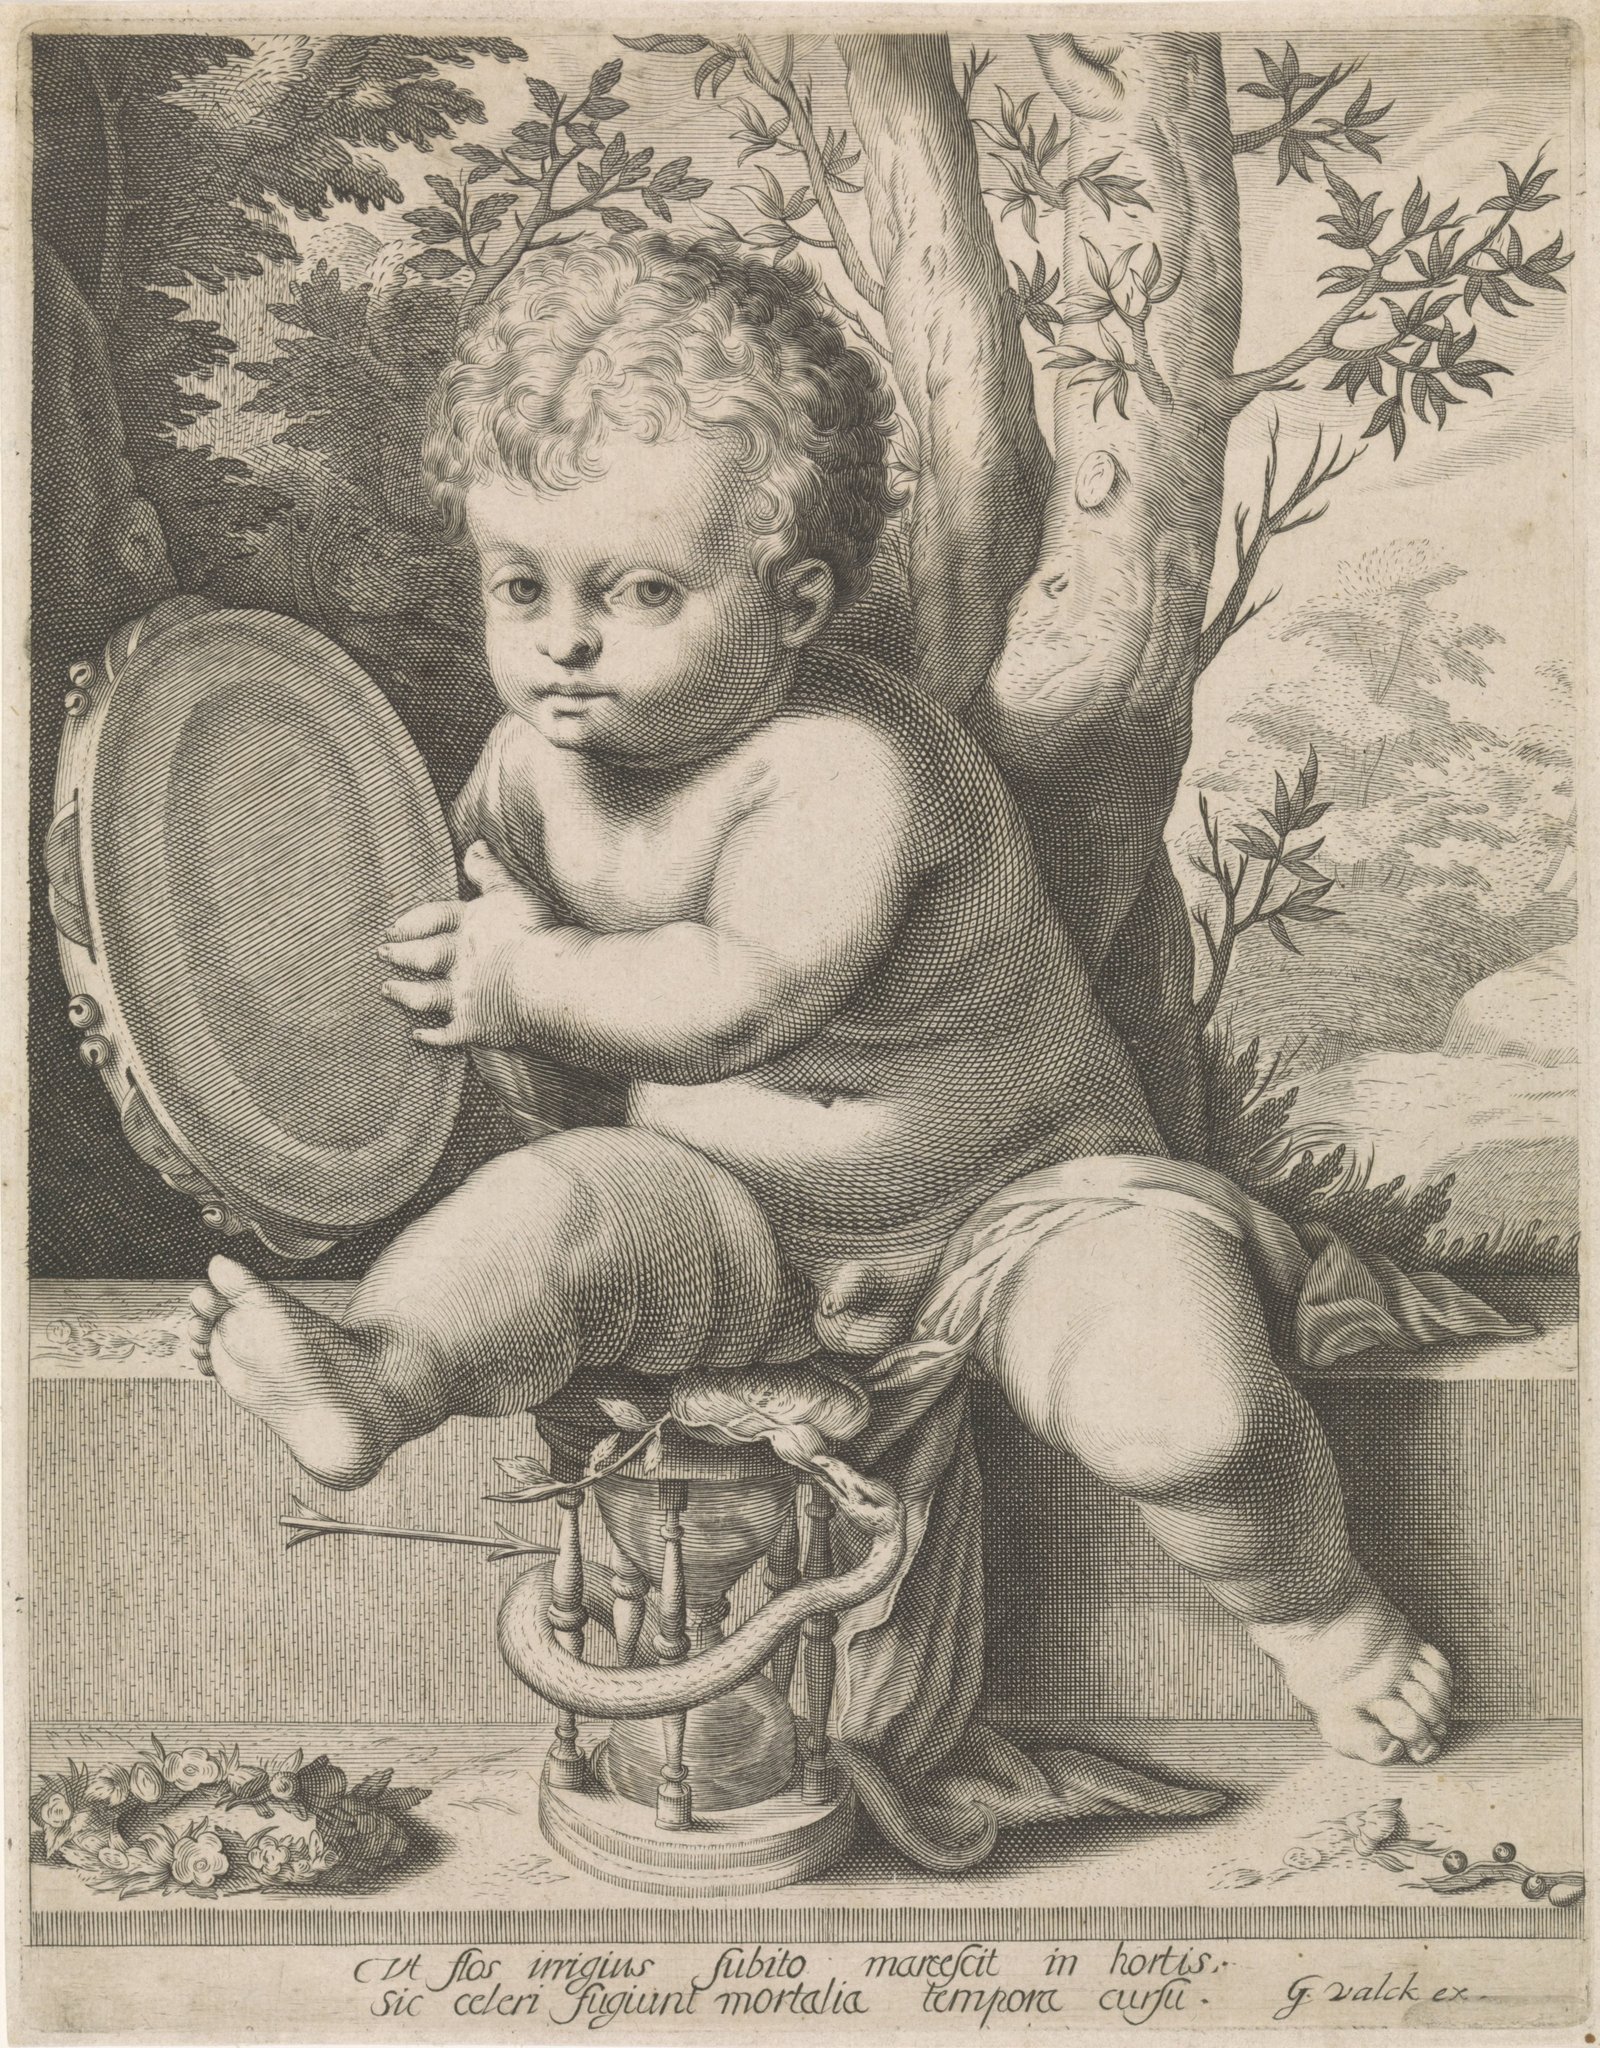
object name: print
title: Kind met tamboerijn en zandloper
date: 1675-1725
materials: paper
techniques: engraving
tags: child, tambourine, hourglass, snakes (+ animals used symbolically)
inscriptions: collector's mark: ‘F.Rechberger 1804’ Lugt 2133, collector's mark: Lugt 2228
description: Een kind, zittend op een plint in een landschap, speelt op een tamboerijn. Voor hem een zandloper waar een slang omheen kronkelt.